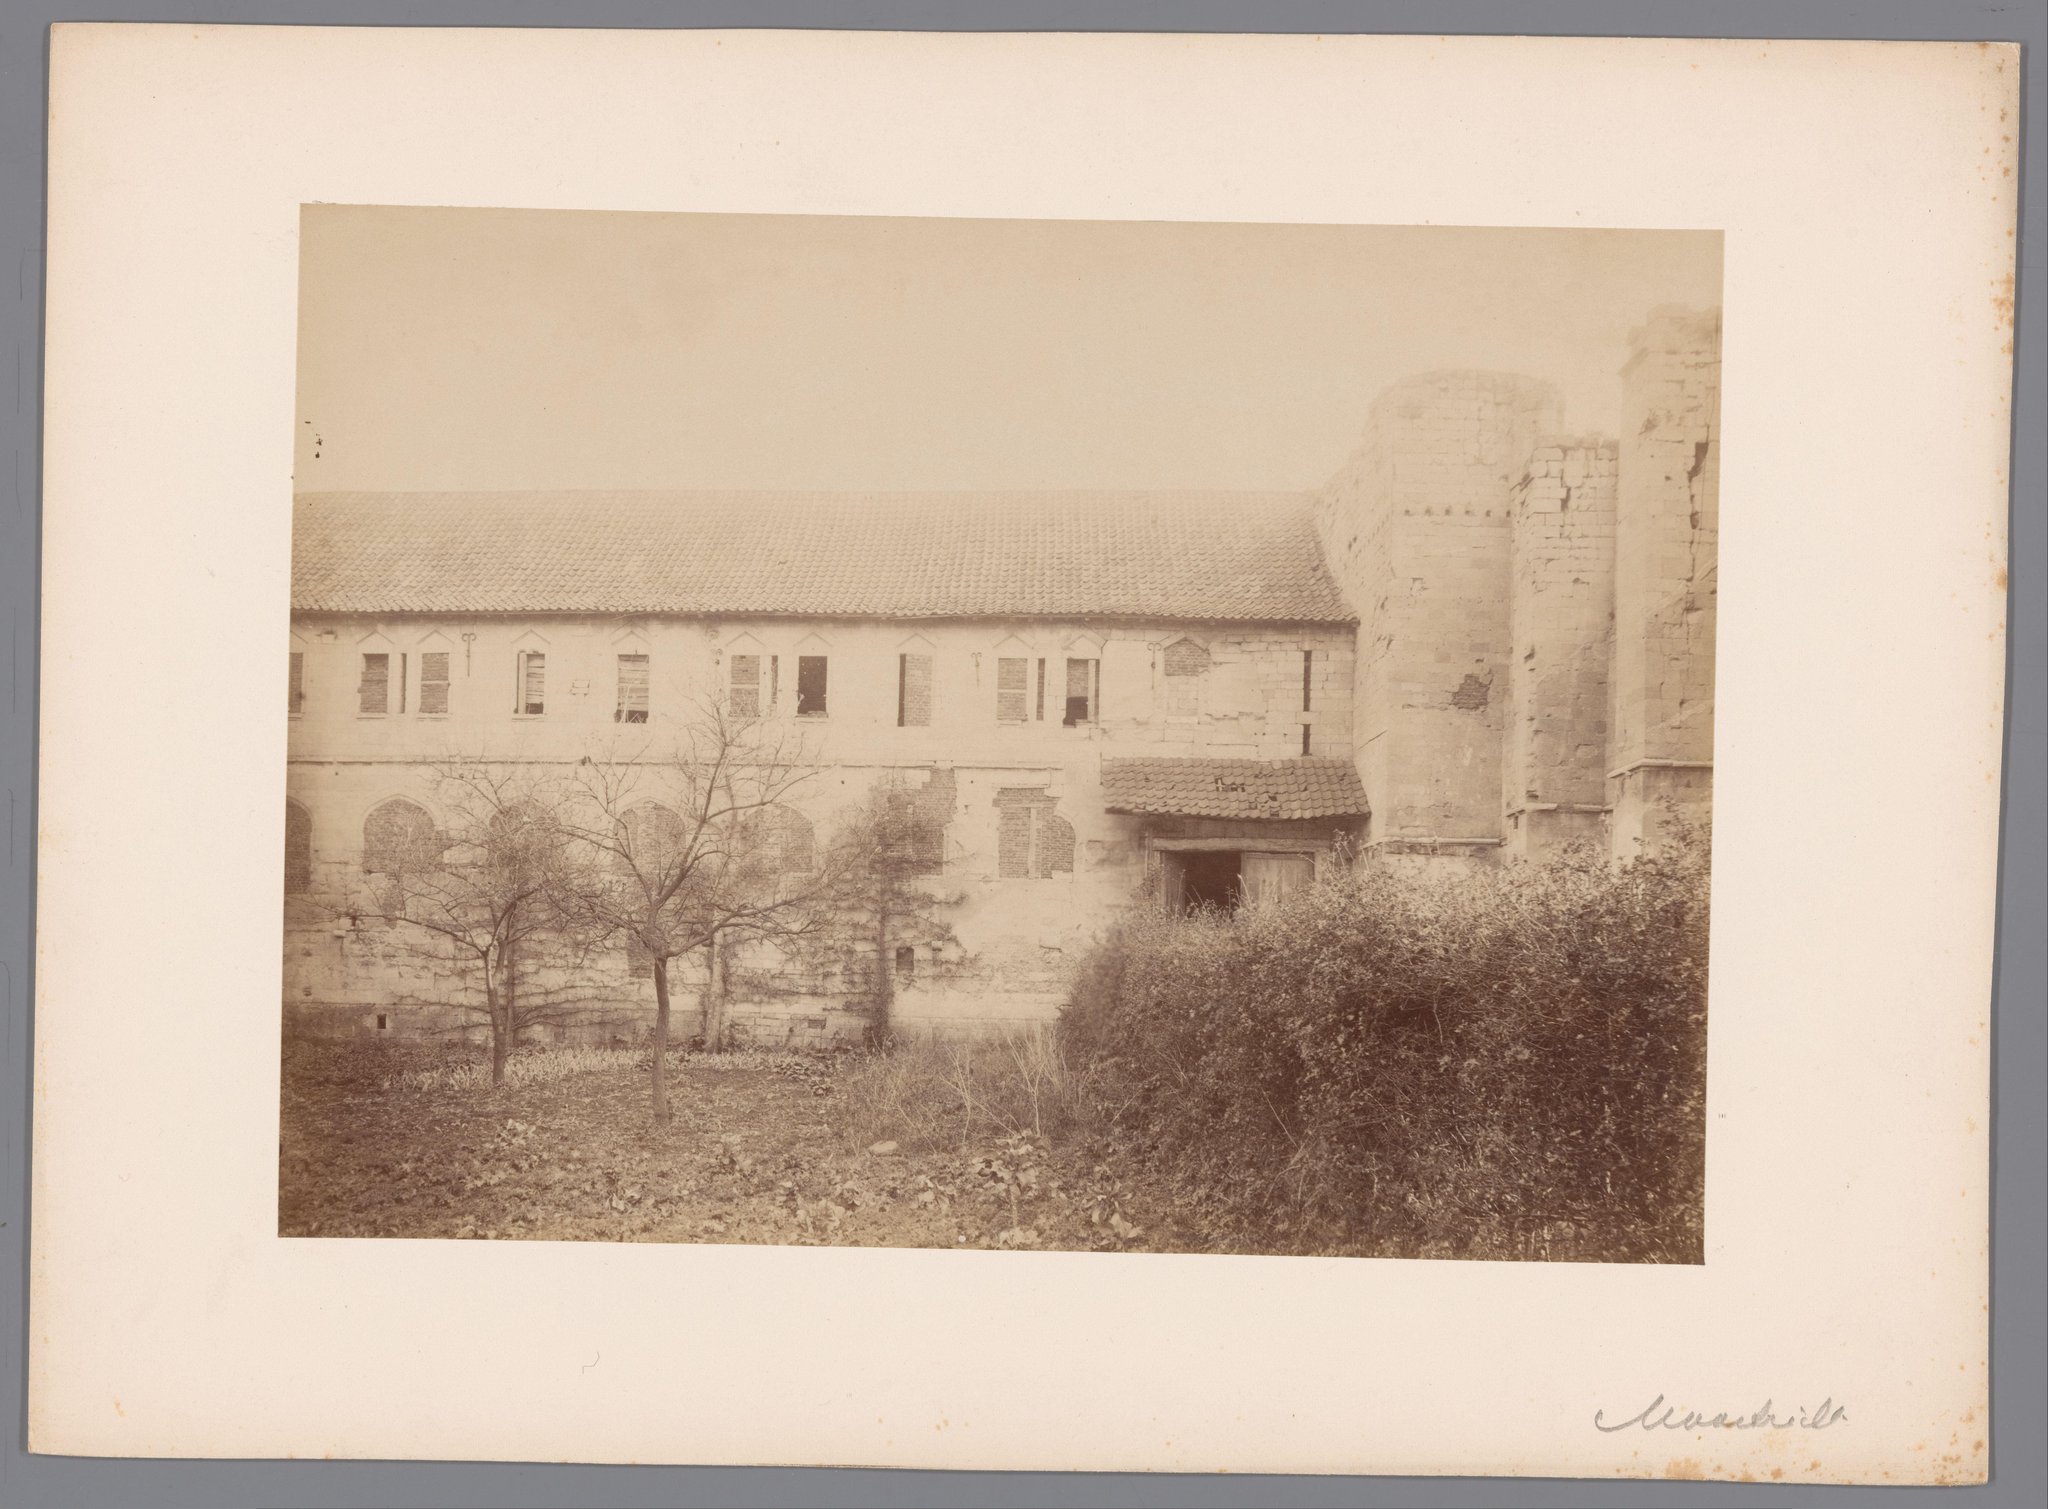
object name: photograph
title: Binnenplaats van het oude Beyart klooster te Maastricht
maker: anoniem (monumentenzorg)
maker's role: fotograaf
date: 1893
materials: cardboard, photographic support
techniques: albumen print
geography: maastricht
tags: ruin of church, monastery, etc.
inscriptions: annotation: ‘Maastricht’, annotation: ‘Maastricht (L.)/ Beyaertgebouwen/ gezien vanaf punt a’